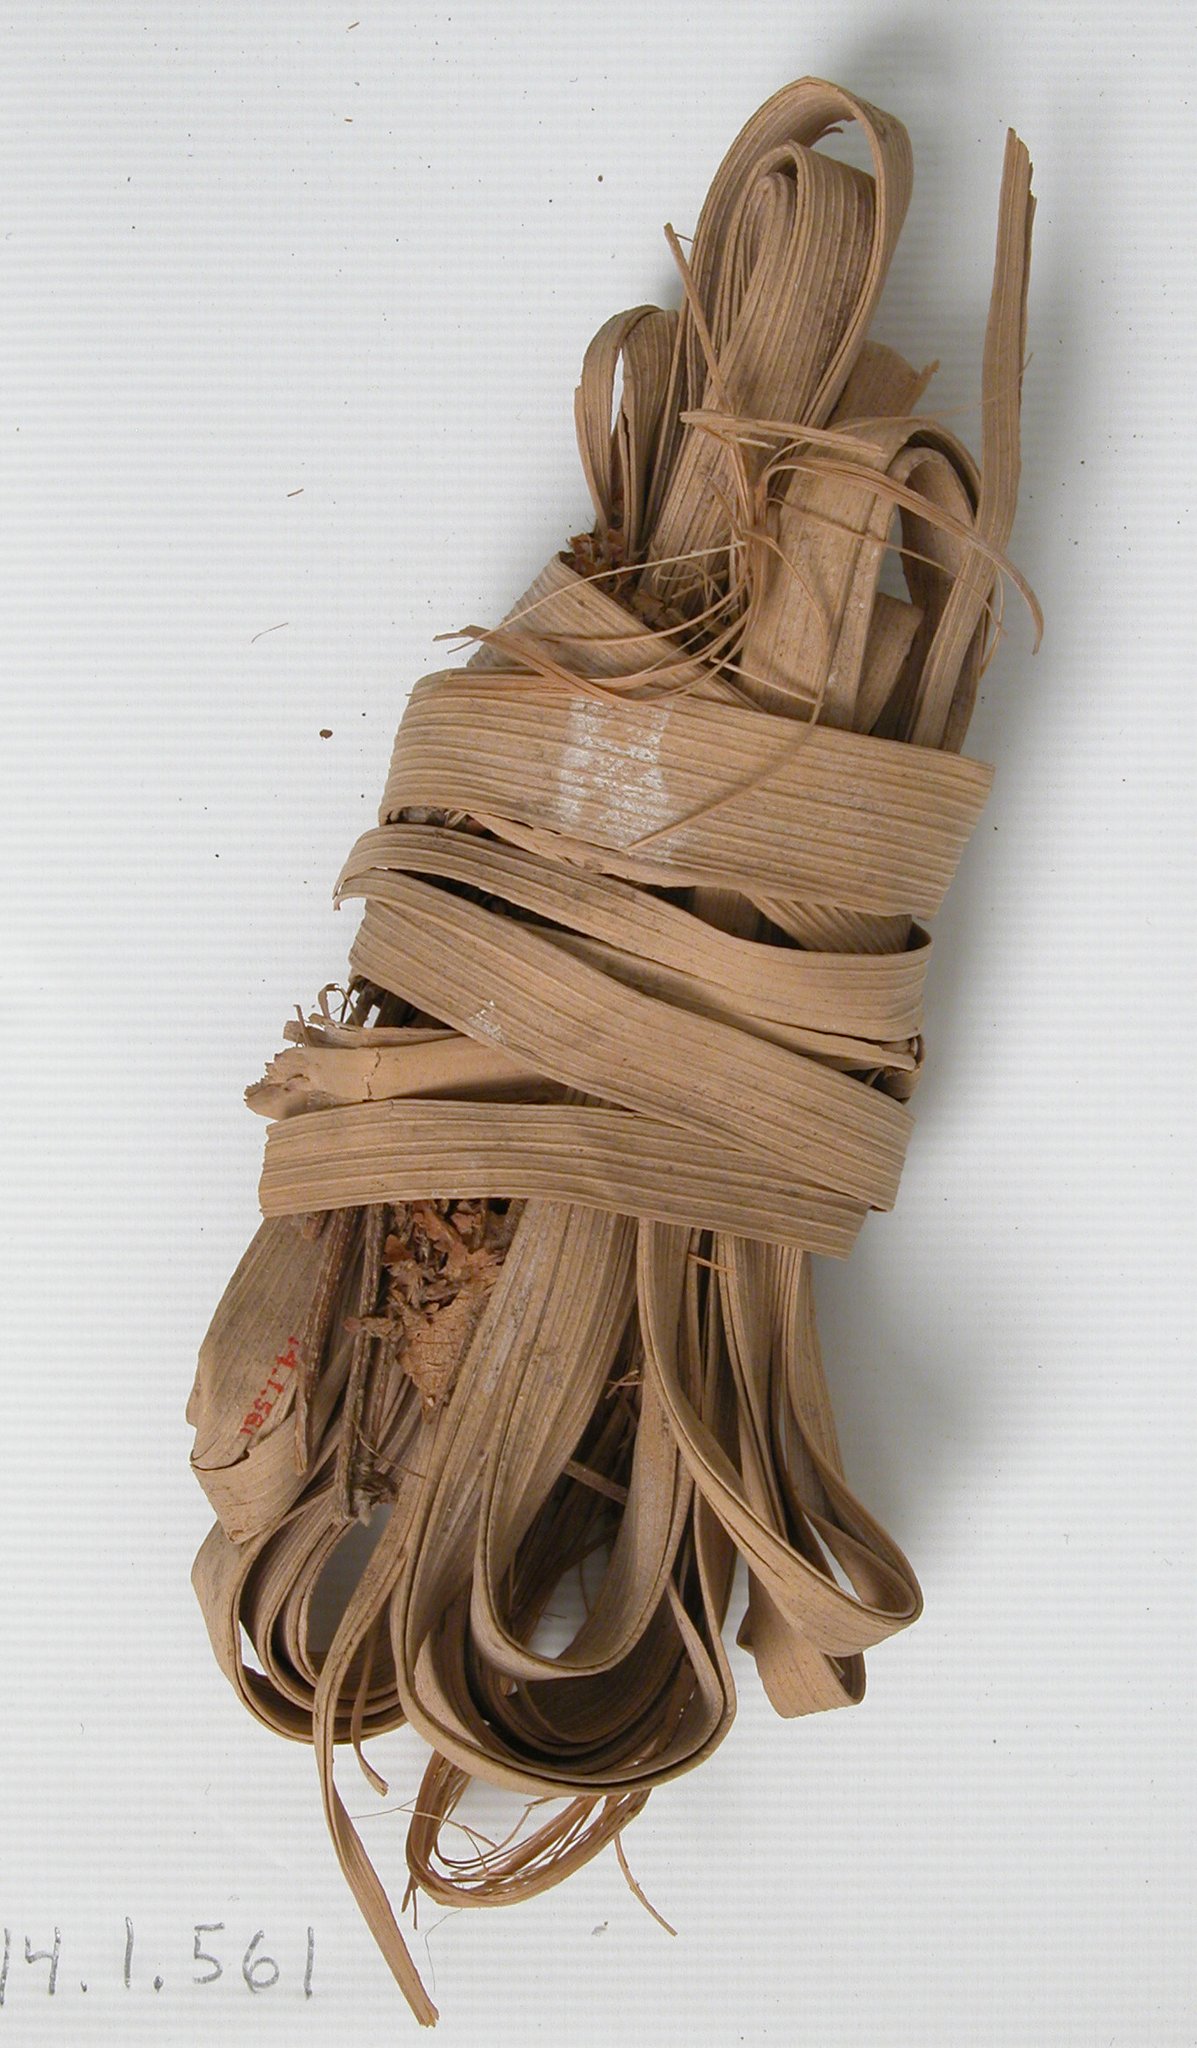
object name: palm leaf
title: Twist of a Palm Leaf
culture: coptic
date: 580-640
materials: fiber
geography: egypt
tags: leaves